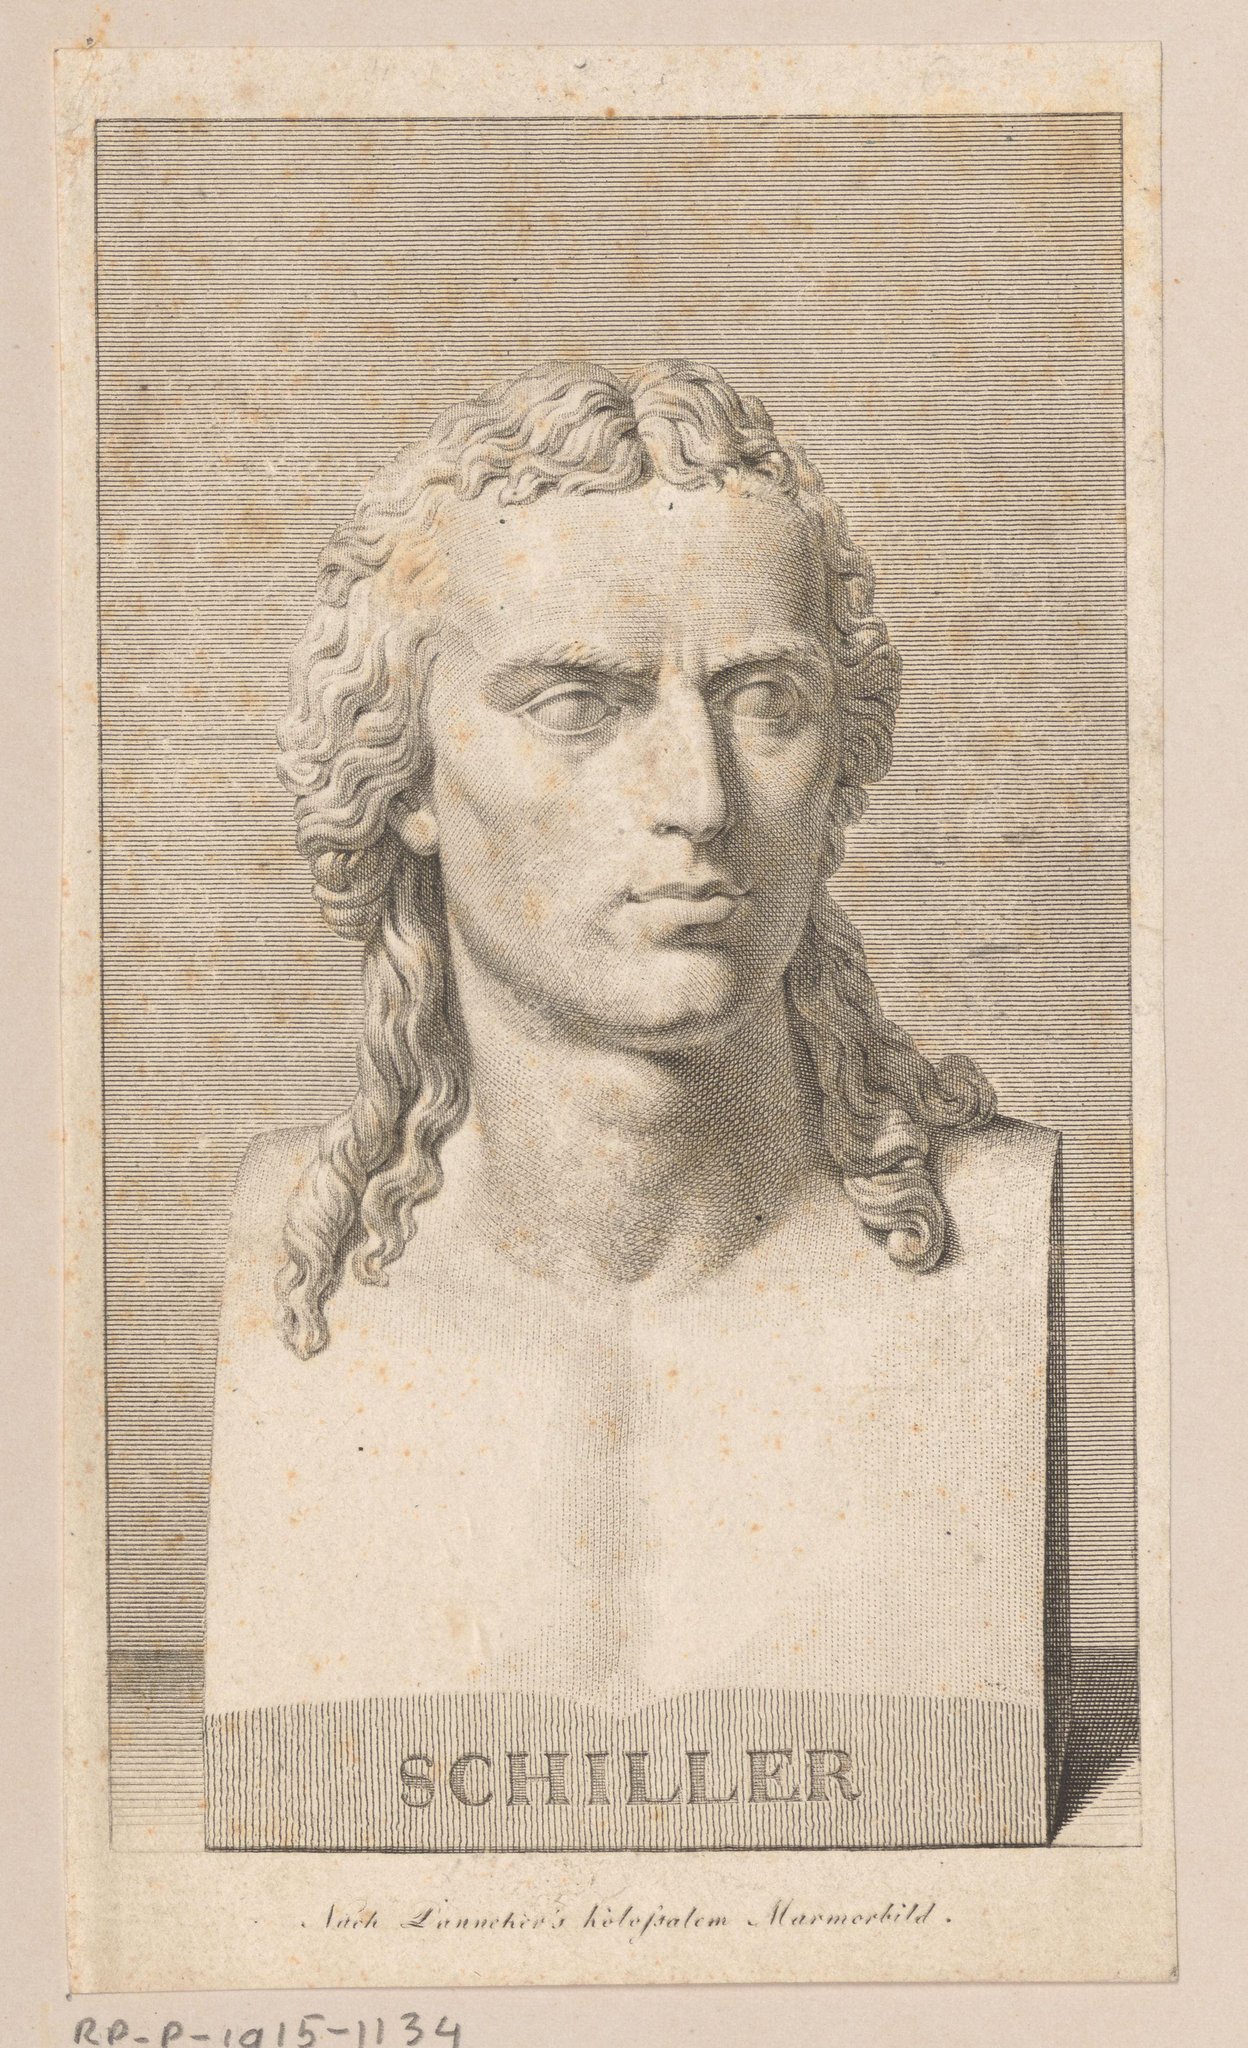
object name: print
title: Portret van Friedrich von Schiller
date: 1805-1860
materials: paper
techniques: engraving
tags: friedrich von schiller, scholar, philosopher, historical persons, portrait of a writer